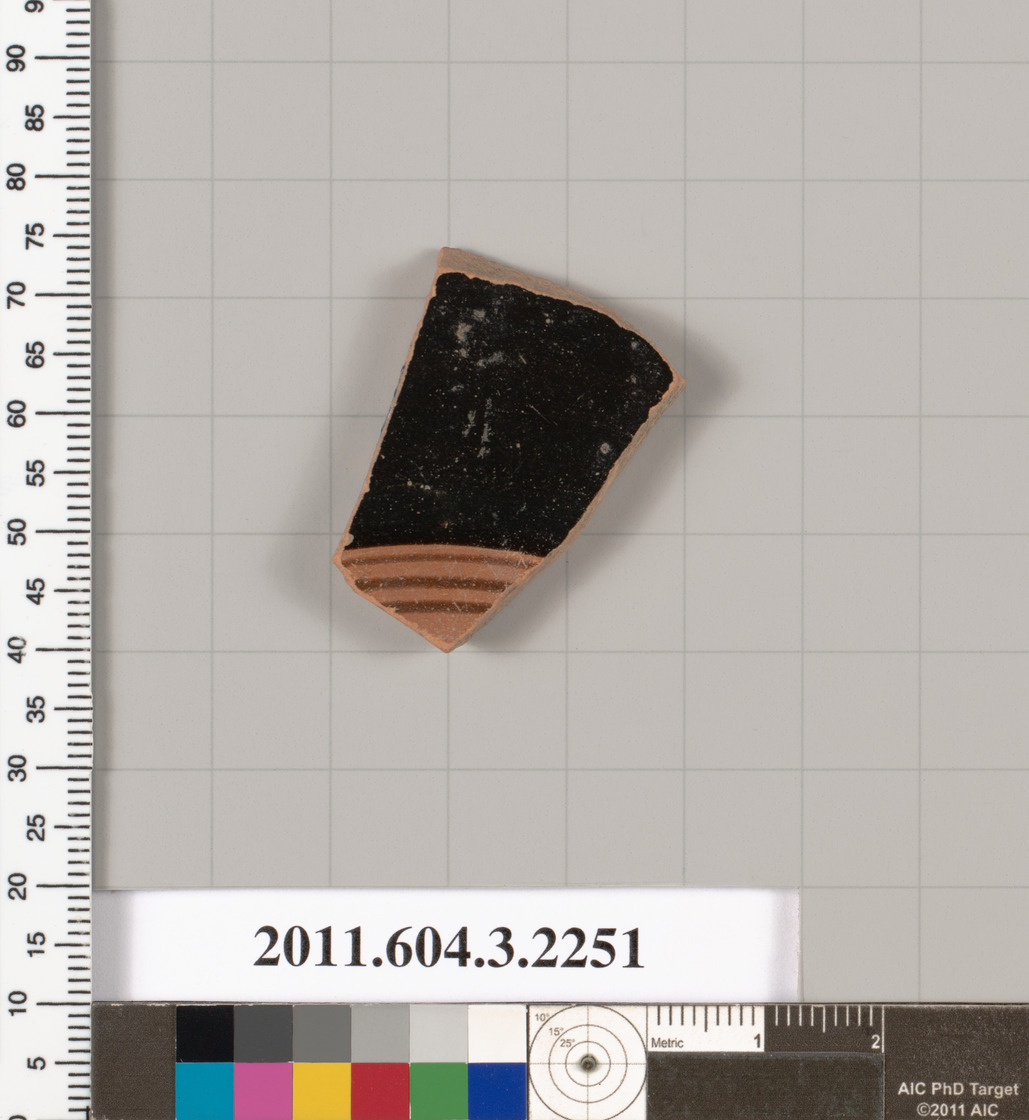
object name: kylix fragment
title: Terracotta fragment of a kylix (drinking cup)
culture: greek, attic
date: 600-401 BCE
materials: terracotta